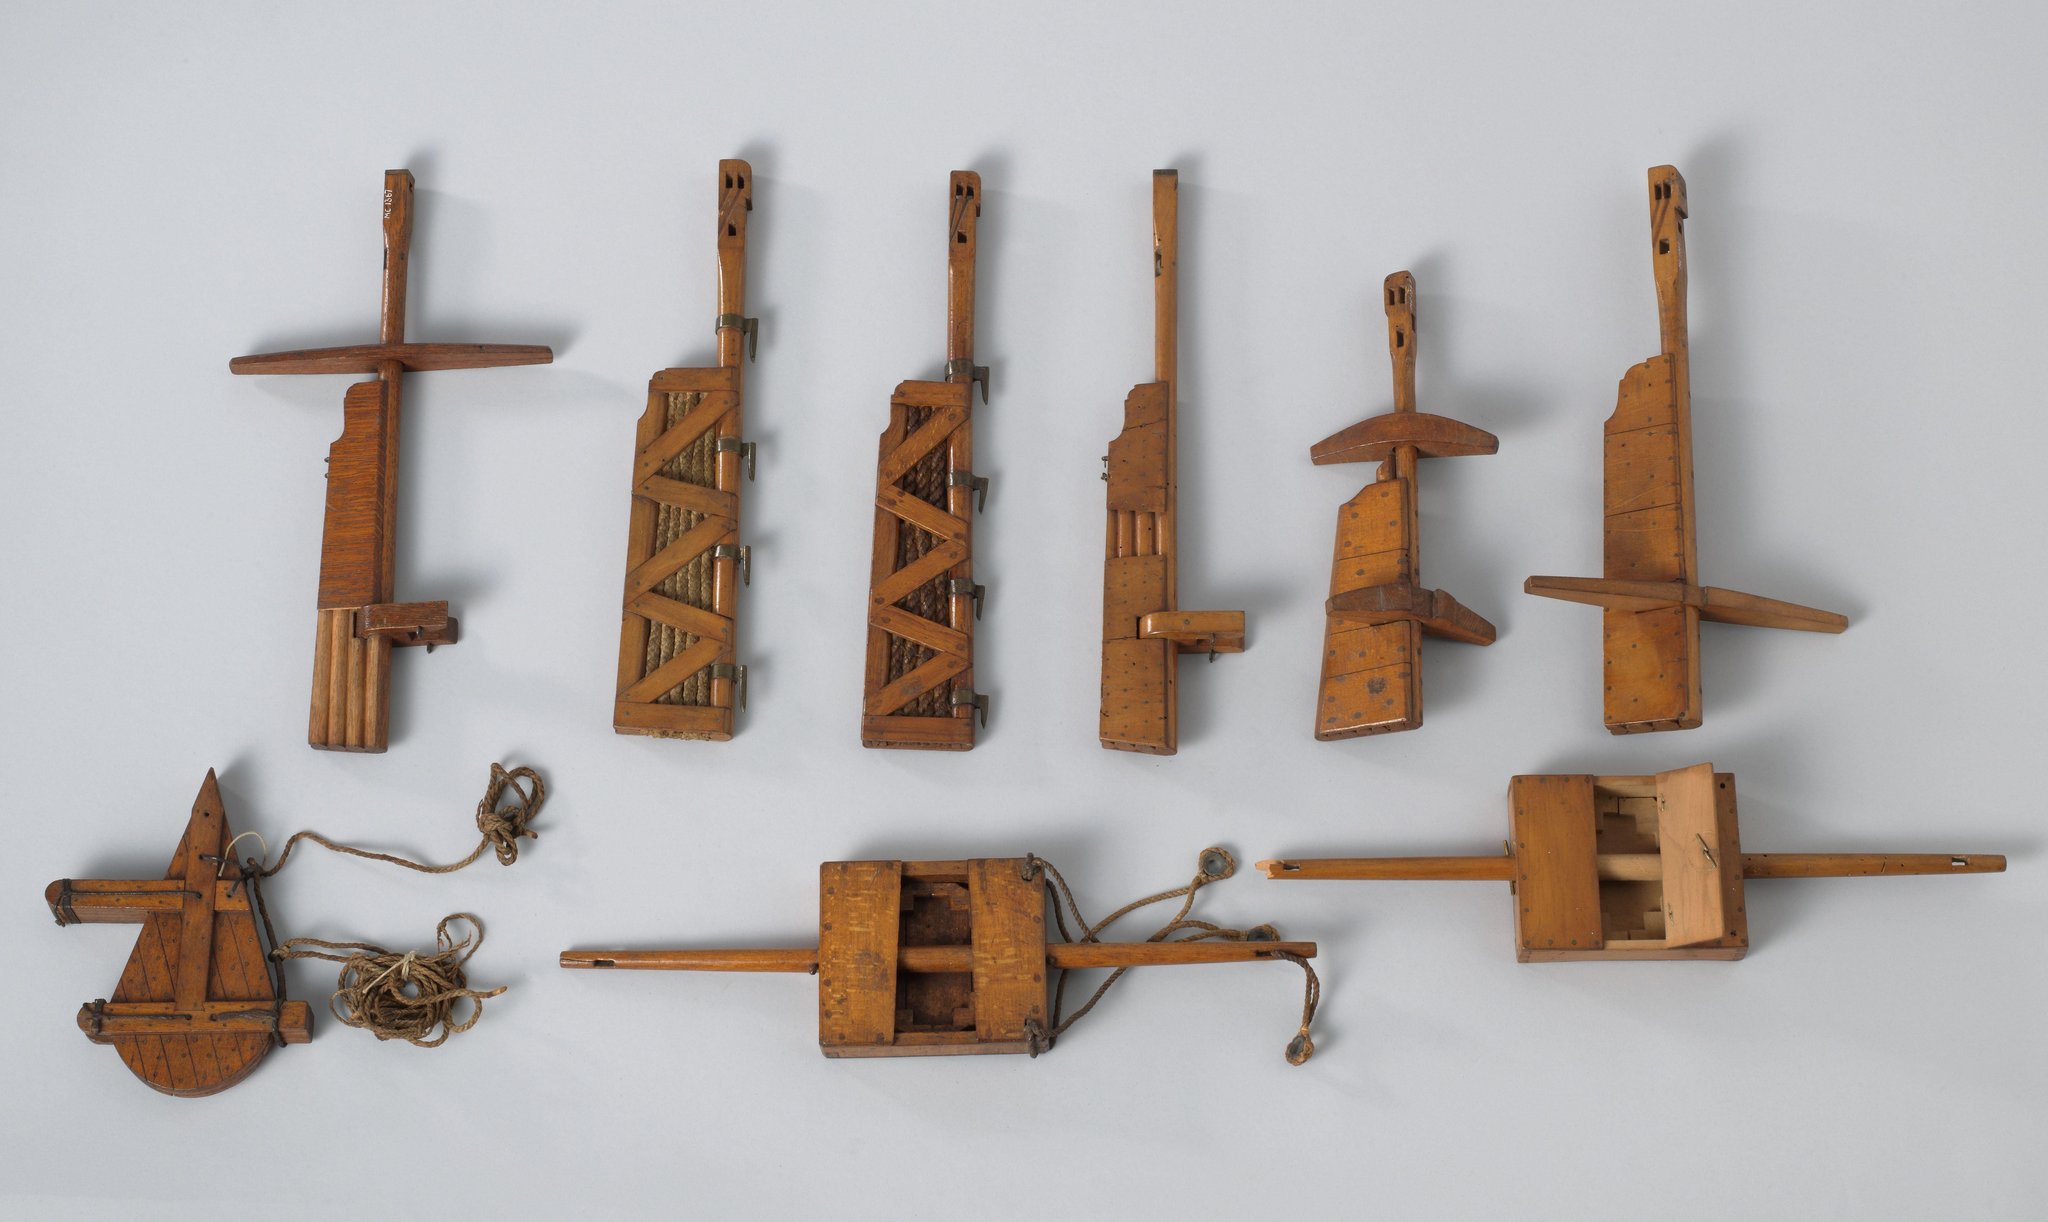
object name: demonstration model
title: Model of a Jury Rudder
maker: Anonymous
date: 1820-1870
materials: brass, wood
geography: netherlands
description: Negen modellen van noodroeren. Drie noodroeren (nrs. 1-3) zijn bijna identiek aan de modellen NG-MC-228, 229 en 230. Ze hebben een steng als roerkoning en het roerblad is samengesteld uit rondhouten met planken bedekt. Twee daarvan (nrs. 1-2) hebben een ezelshoofd als roerhaak om de koning, bij de derde is hiervoor een ankerstok gebruikt. Eén noodroer (nr. 2) heeft een ankerstok om de roerkop, vergelijkbaar met model NG-MC-229 (Pakenhams noodroer). Het vierde model is een kleinere versie van dit type noodroer en heeft twee korte ankerstokken om de koning, een als roerhaak en een om de roerkop. Twee bijna identieke modellen (nrs. 5-6) zijn noodroeren met een steng als roerkoning en het roerblad is samengesteld uit trossen die door planken bijeen worden gehouden; deze modellen hebben speciale messing roerhaken. Het zevende model, van planken gemaakt, heeft een druppelvorm en is vermoedelijk gebaseerd op het ontwerp van Bassiere. Het laatste paar modellen (nrs. 8-9) bestaat uit een ra waar een kast omheen is gebouwd. De hoeken van de kast zijn aan de binnenkant verstevigd met de wangen van rolpaarden. Eén model (nr. 8) is voorzien van stroppen aan één kant, vermoedelijk voor de bevestiging van stuurtalies.